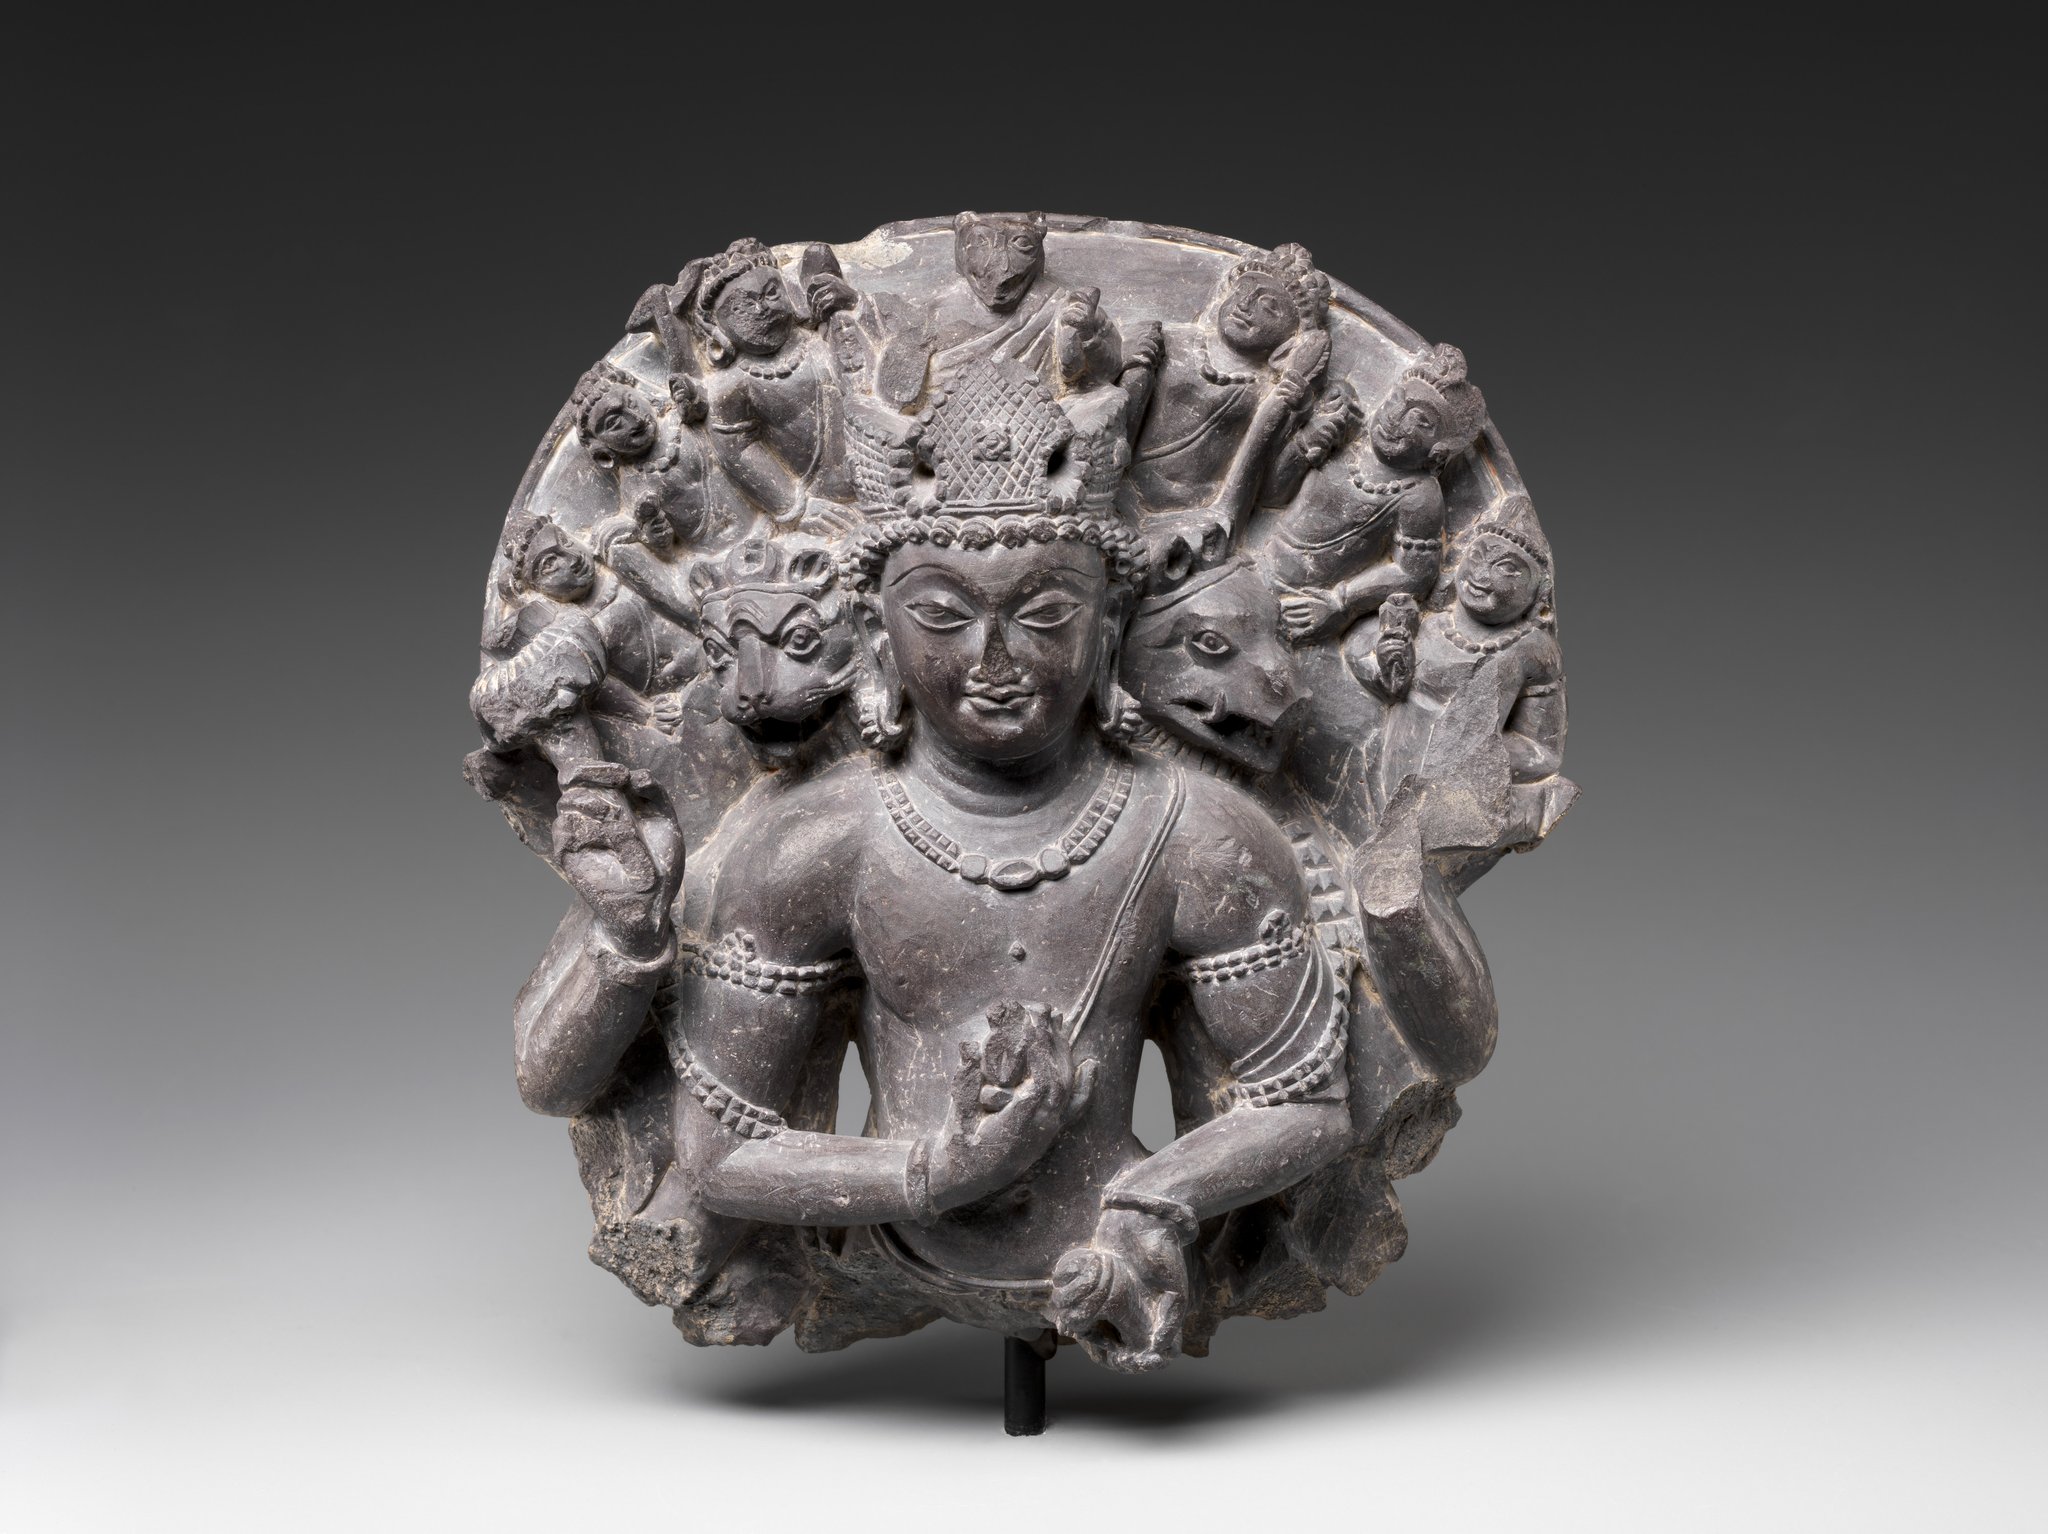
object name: sculpture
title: Vishvarupa Vishnu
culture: kashmiri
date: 501-600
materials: stone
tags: kashmir,vishnu,hinduism